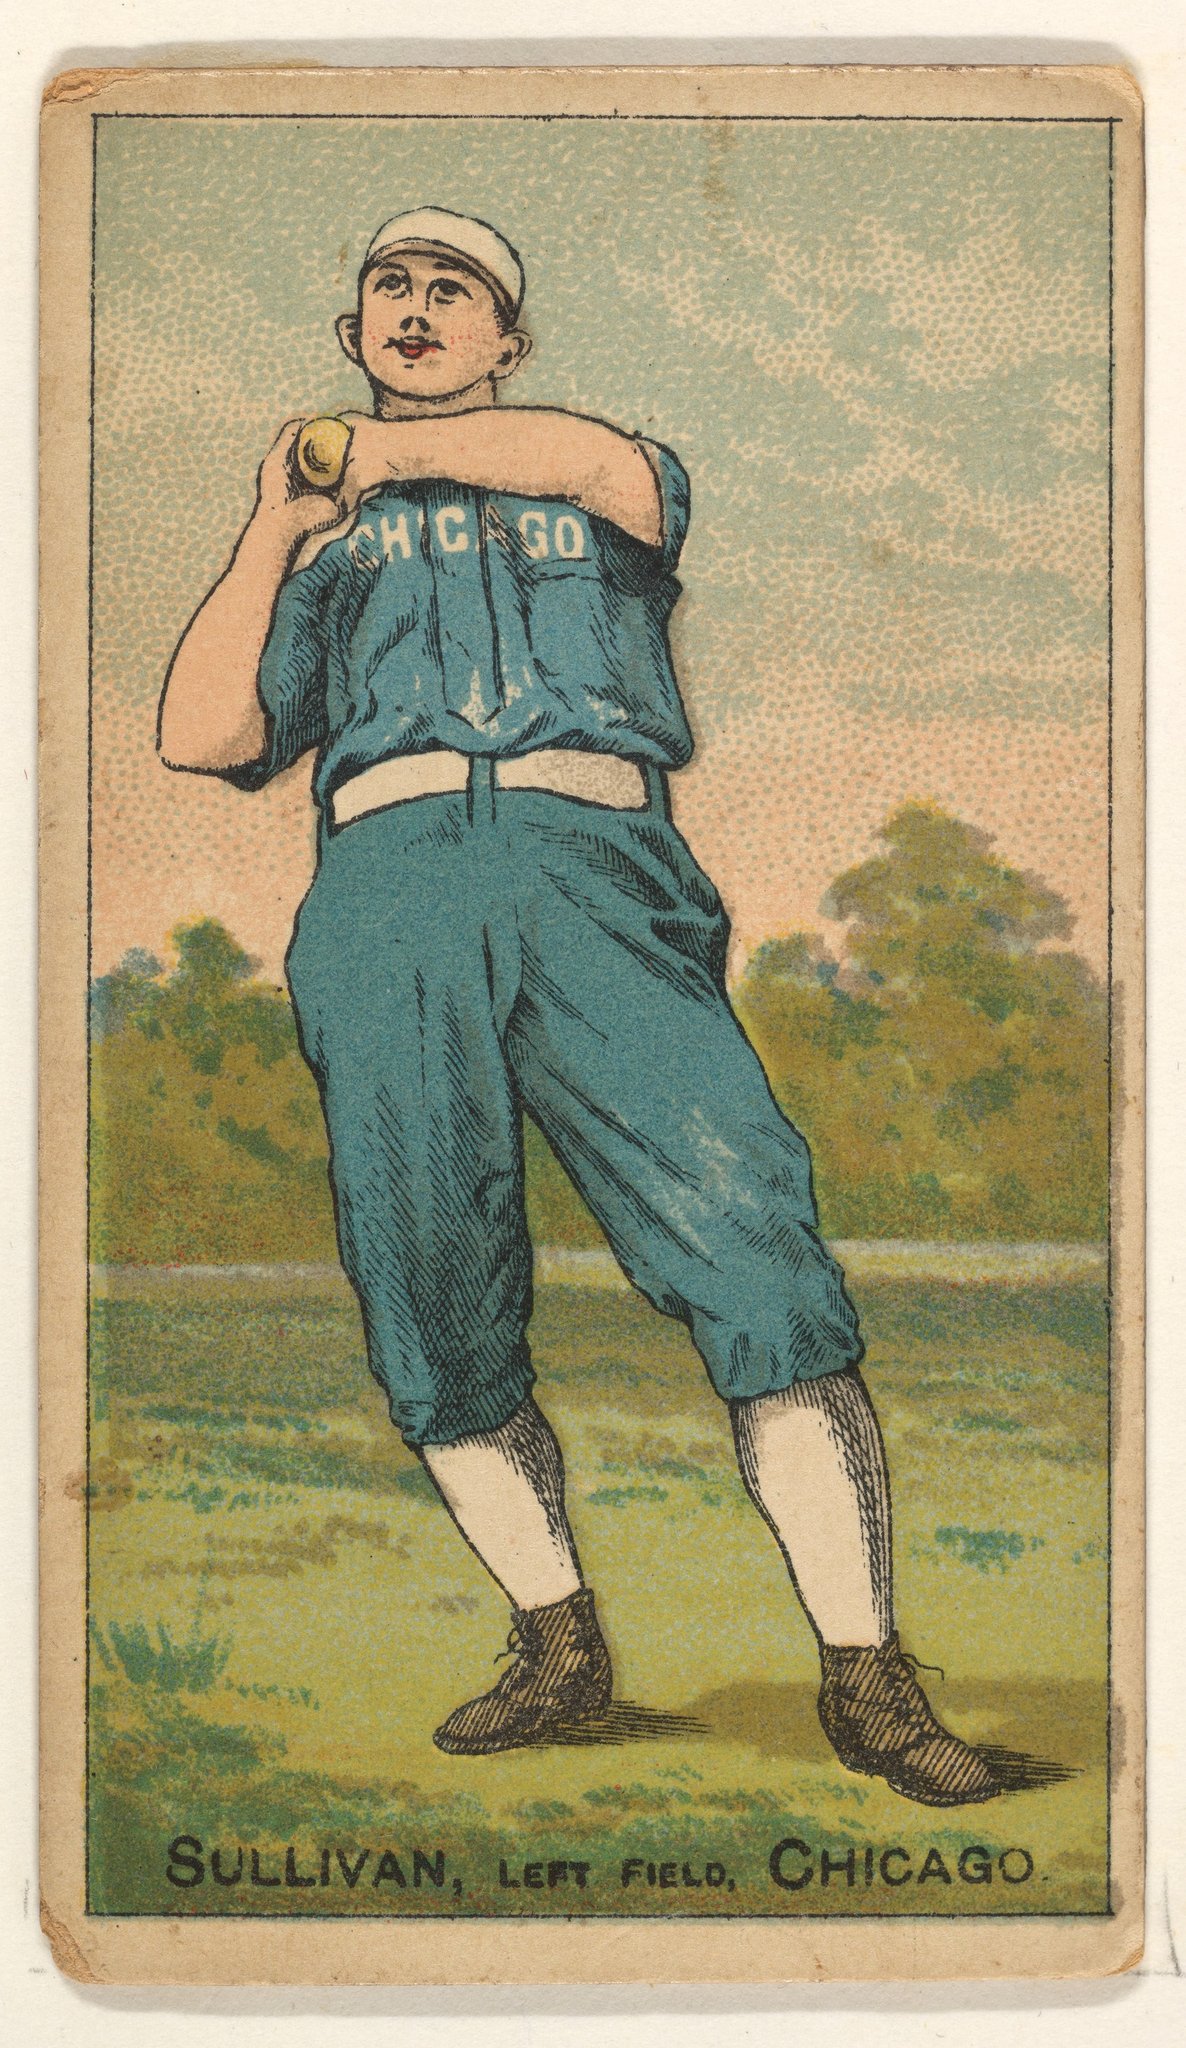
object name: baseball card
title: Sullivan, Left Field, Chicago, from the Gold Coin series (N284) for Gold Coin Chewing Tobacco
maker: d. buchner & co., new york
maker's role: publisher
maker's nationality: american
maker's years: 1850-1900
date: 1887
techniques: color lithograph, drawing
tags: men,baseball,athletes